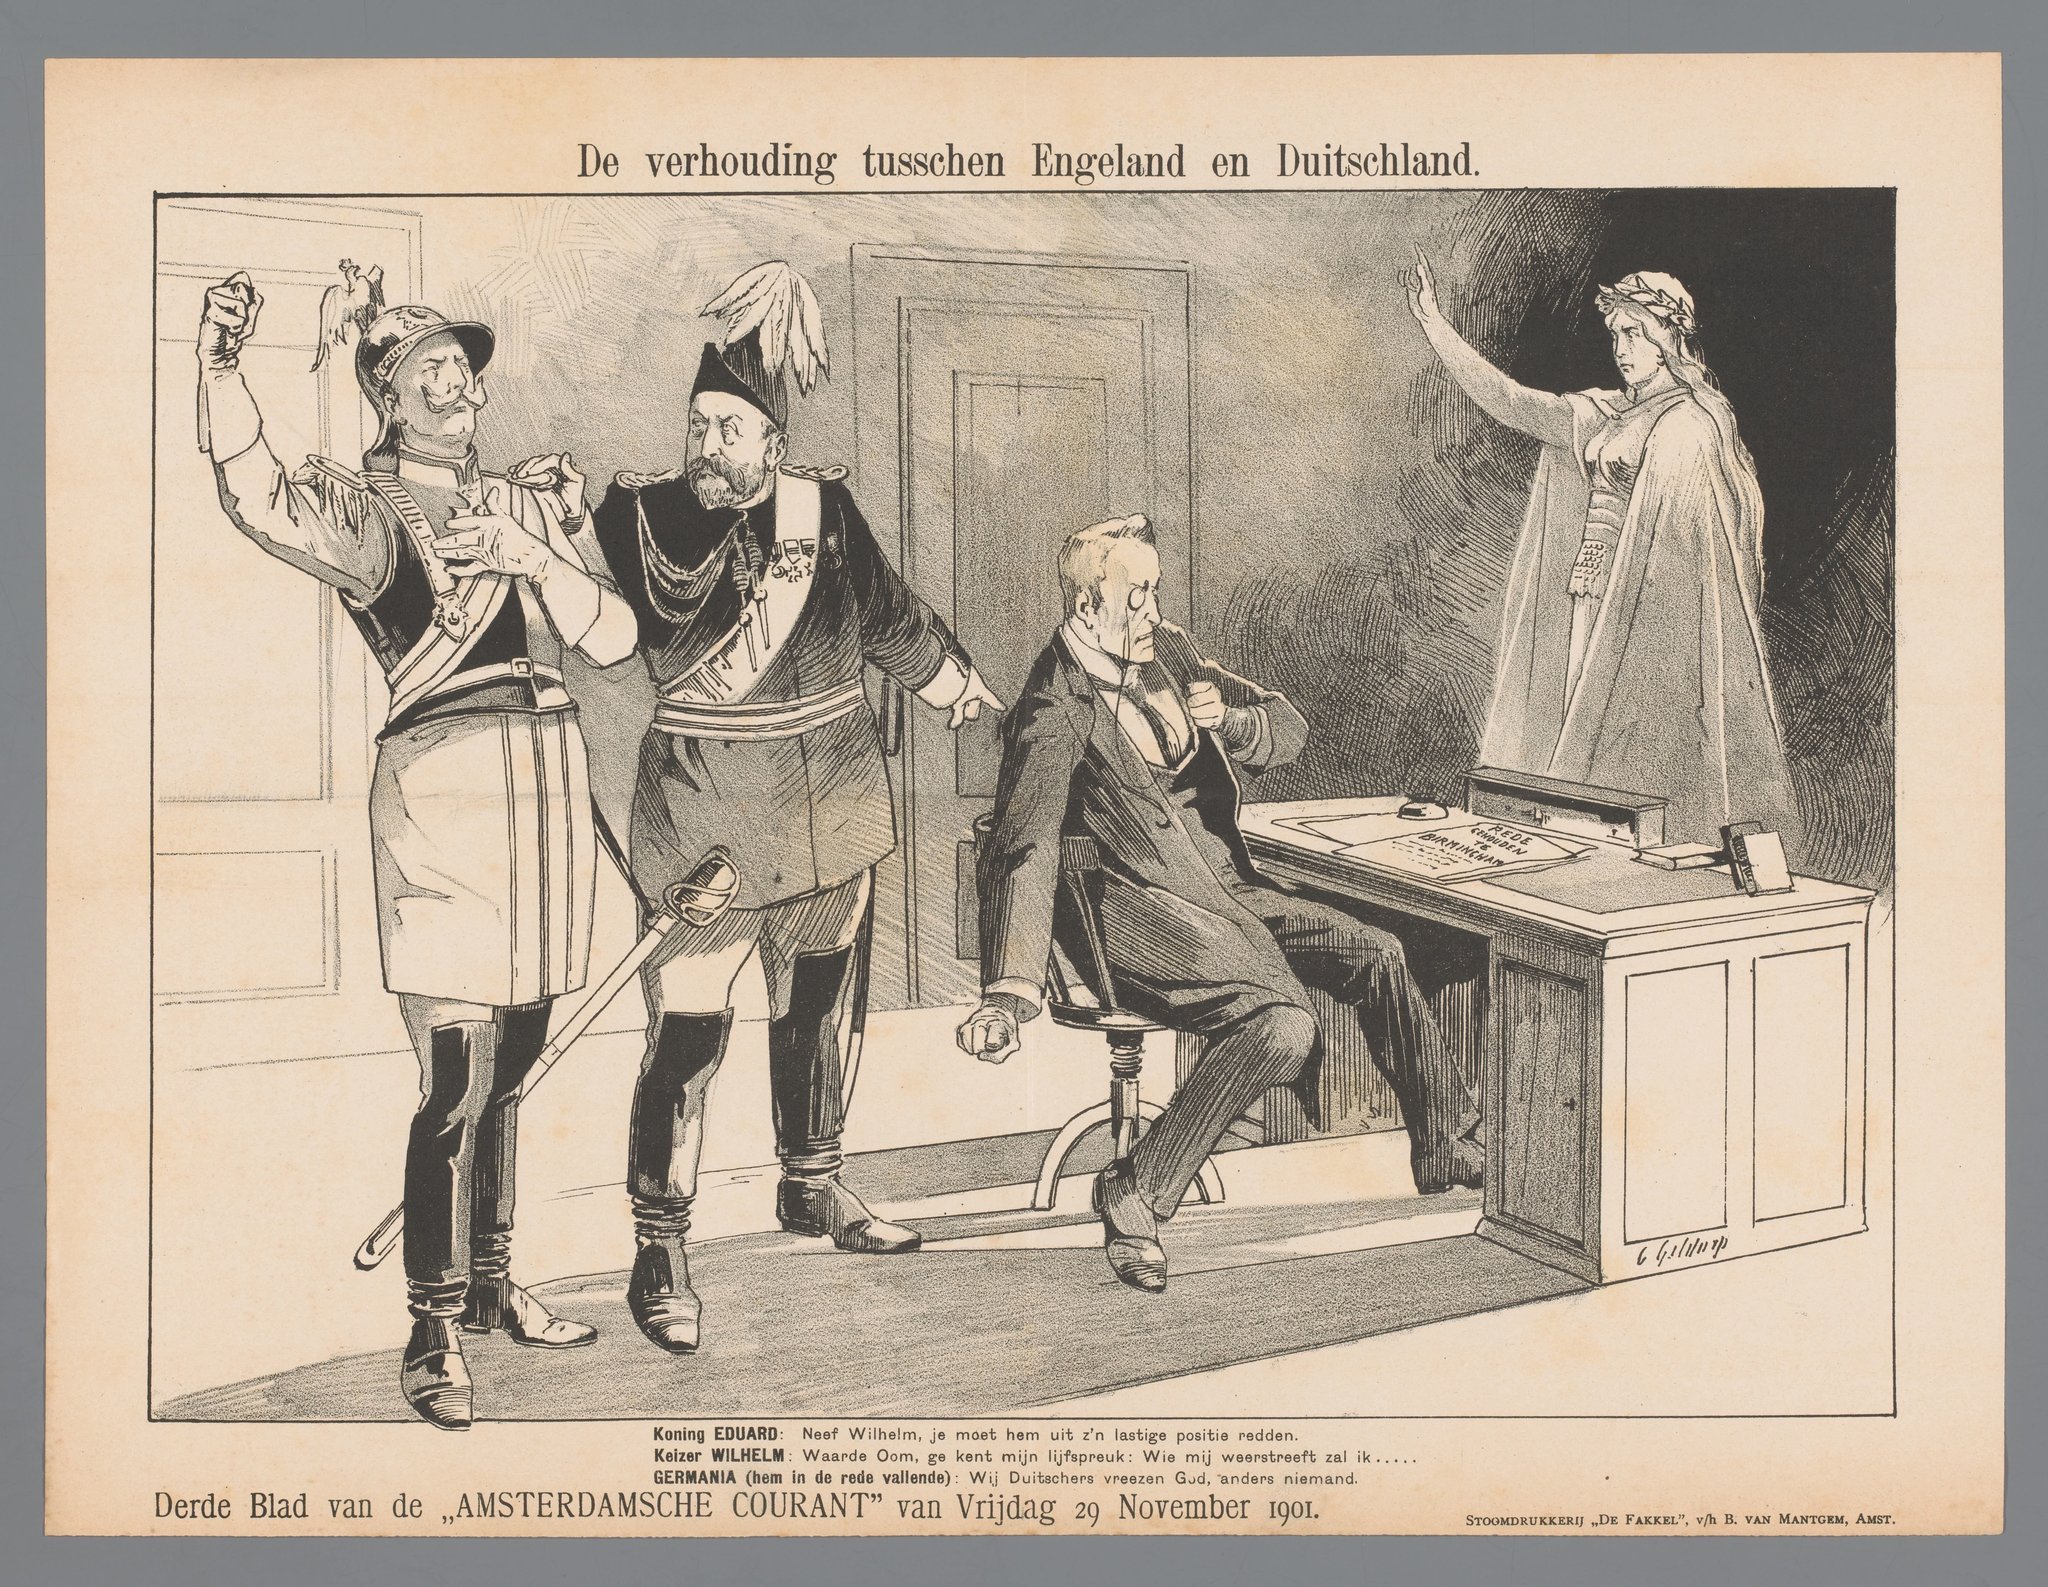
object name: cartoon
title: De verhouding tusschen Engeland en Duitschland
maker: petrus van geldorp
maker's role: draughtsman, print maker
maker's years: 1872-1939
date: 1901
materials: paper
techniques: lithograph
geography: amsterdam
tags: wilhelm ii (keizer van duitsland), personifications of countries, nations, states, districts, etc., historical persons, ruler, sovereign, political caricatures and satires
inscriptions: date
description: Prent uit het bijvoegsel van: De Amsterdamsche Courant, 29 november 1901.